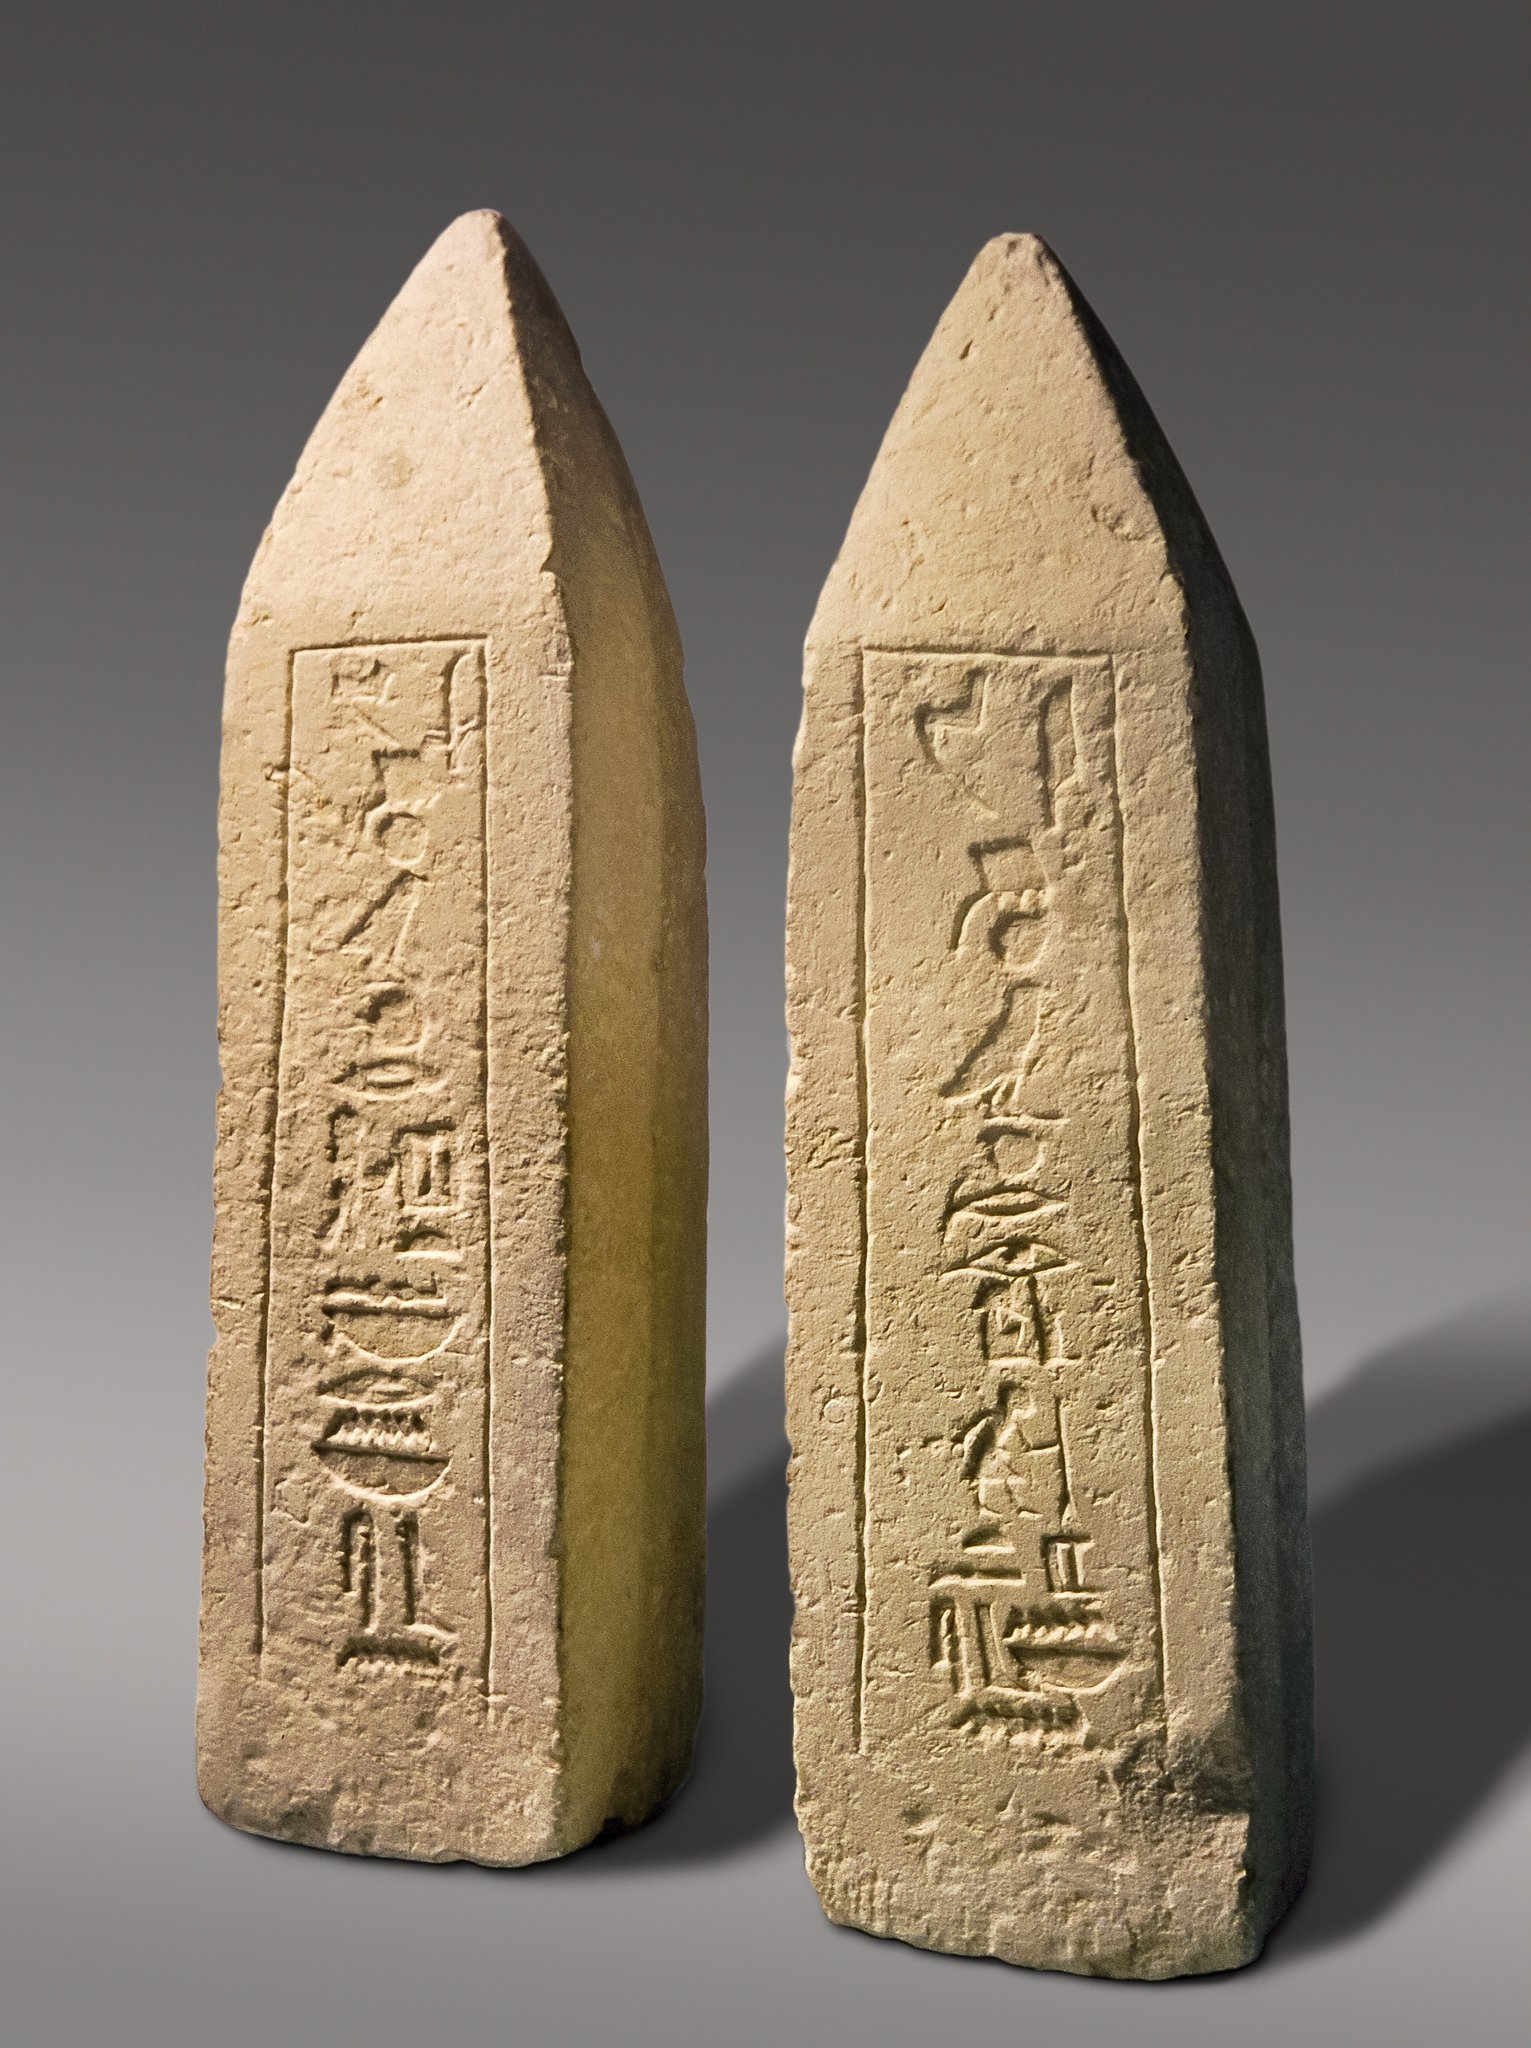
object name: obelisk, nebsen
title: Pair of Obelisks of Nebsen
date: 2323-2100 BCE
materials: limestone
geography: egypt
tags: obelisks,hieroglyphs